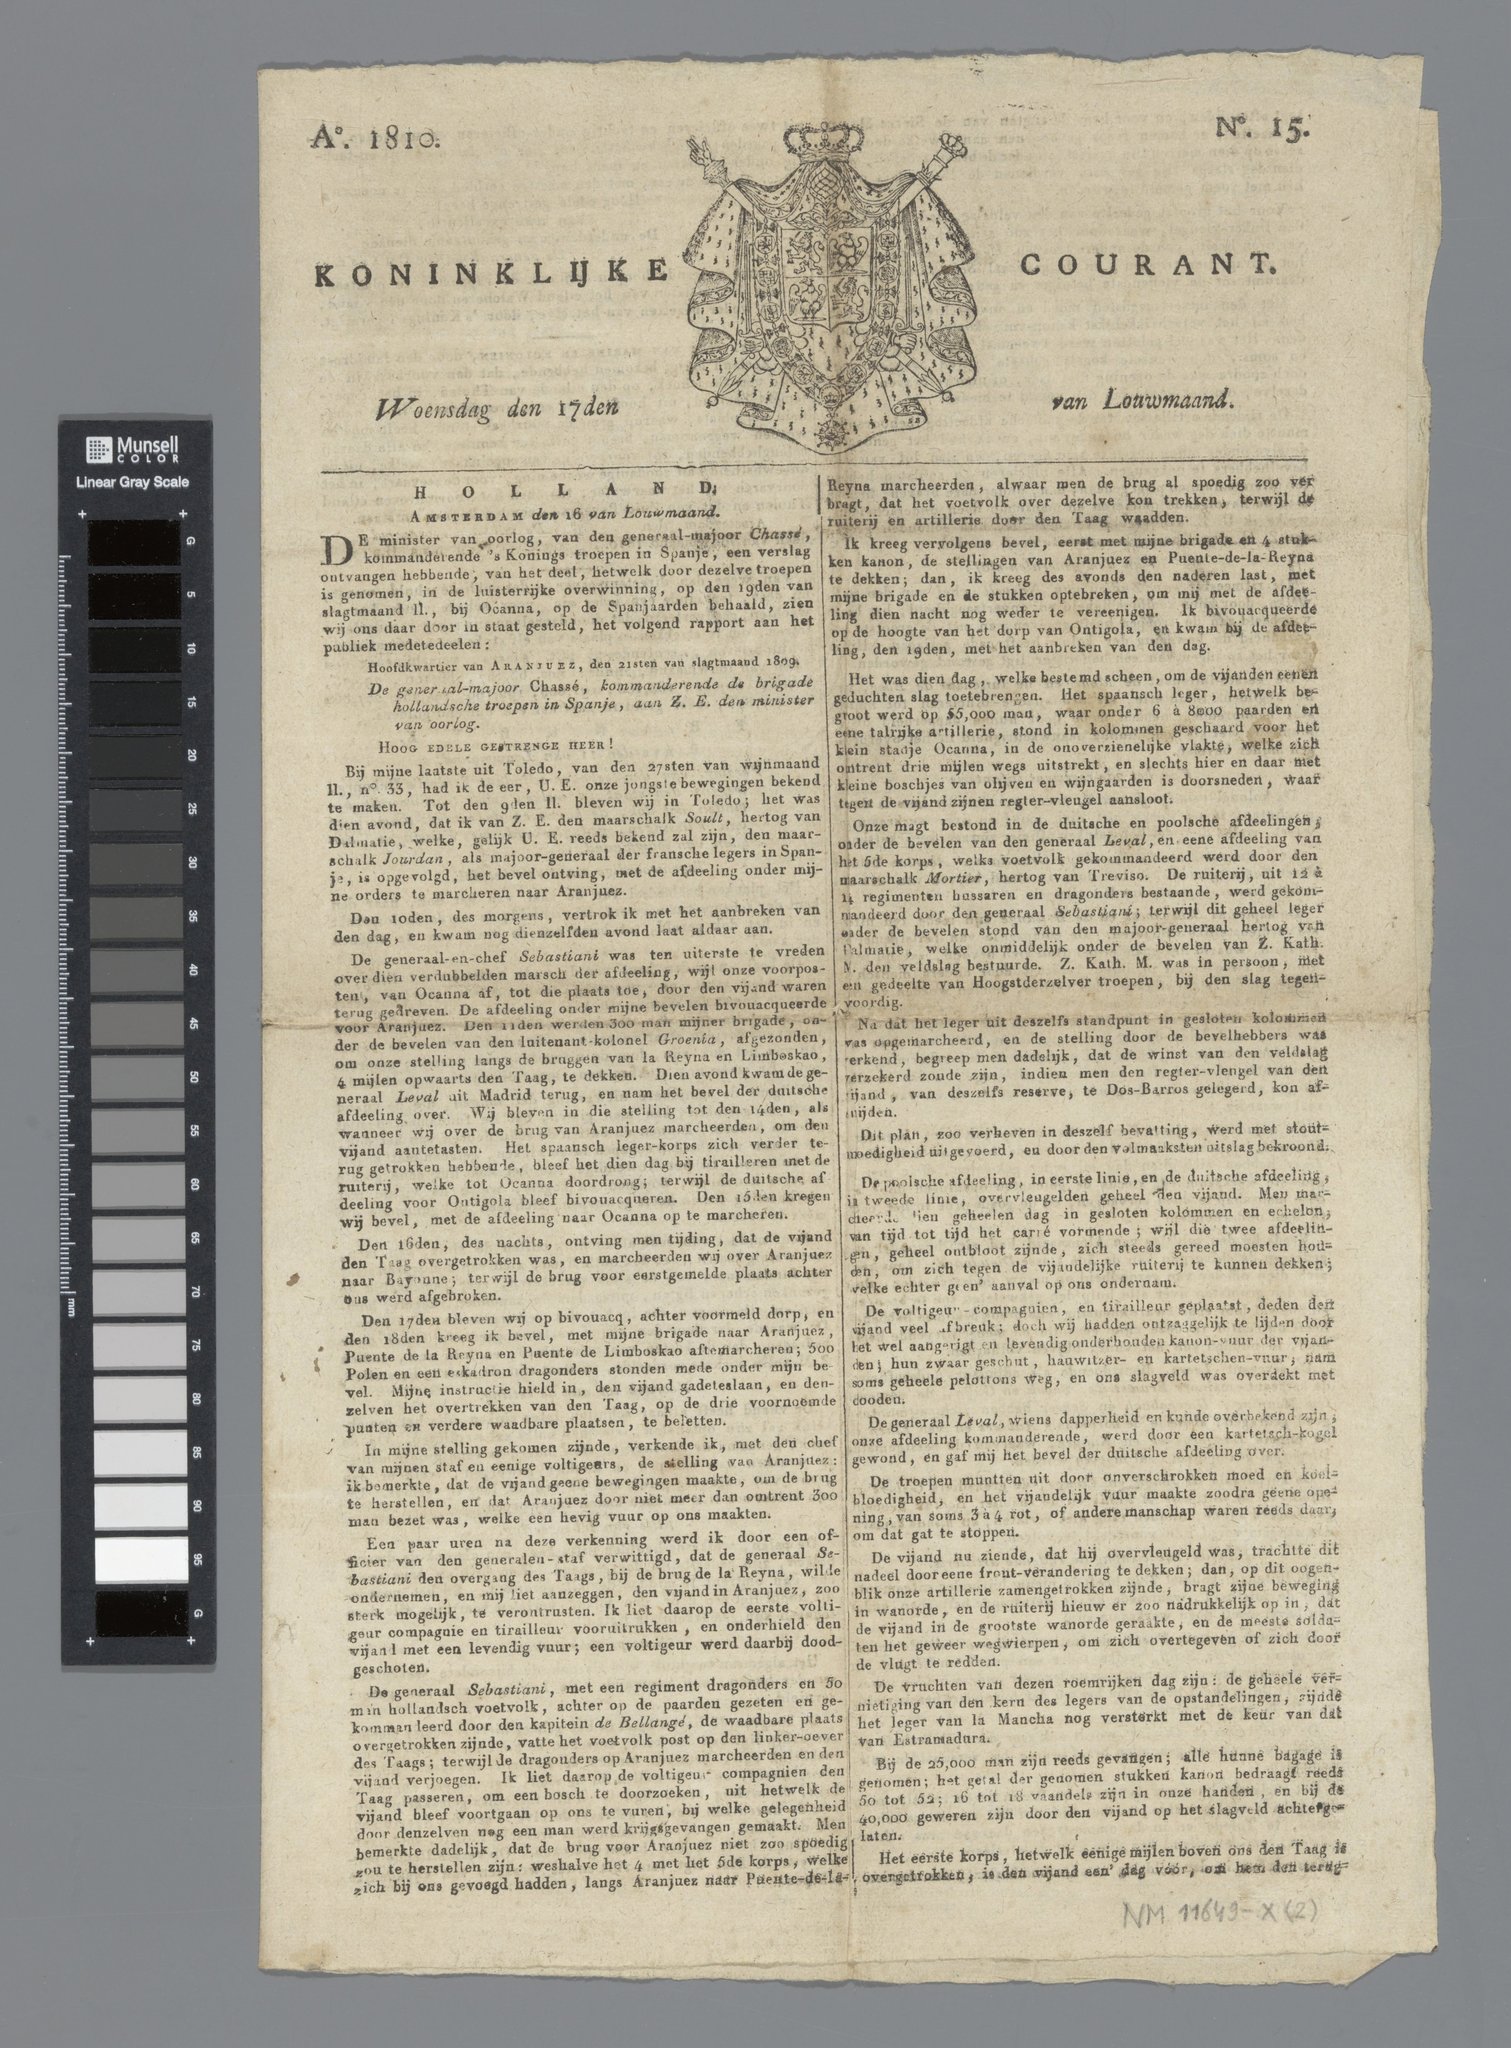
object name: newspaper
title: Koninklijke Courant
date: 1810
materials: paper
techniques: printing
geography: amsterdam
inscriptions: date